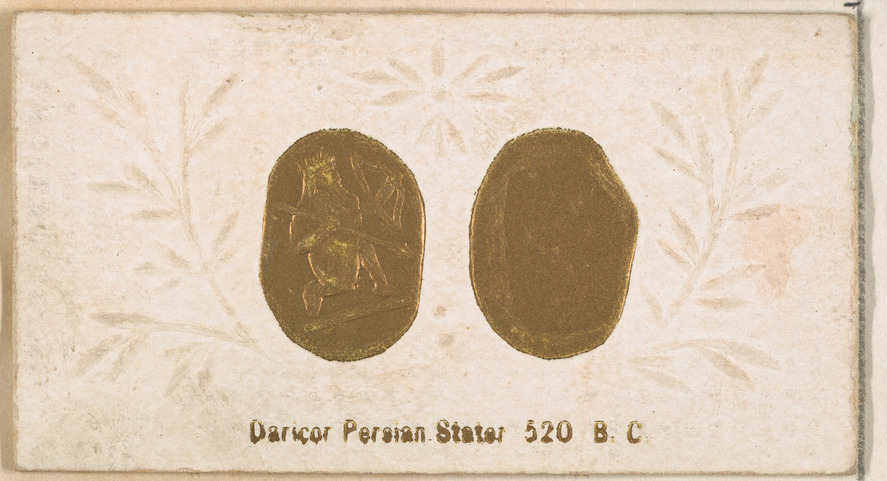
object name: print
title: Daricor Persian Stater, 520 B.C., from the Ancient Coins series (N180) issued by Wm. S. Kimball & Co.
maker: william s. kimball & company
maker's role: publisher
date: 1888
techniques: color lithograph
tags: coins